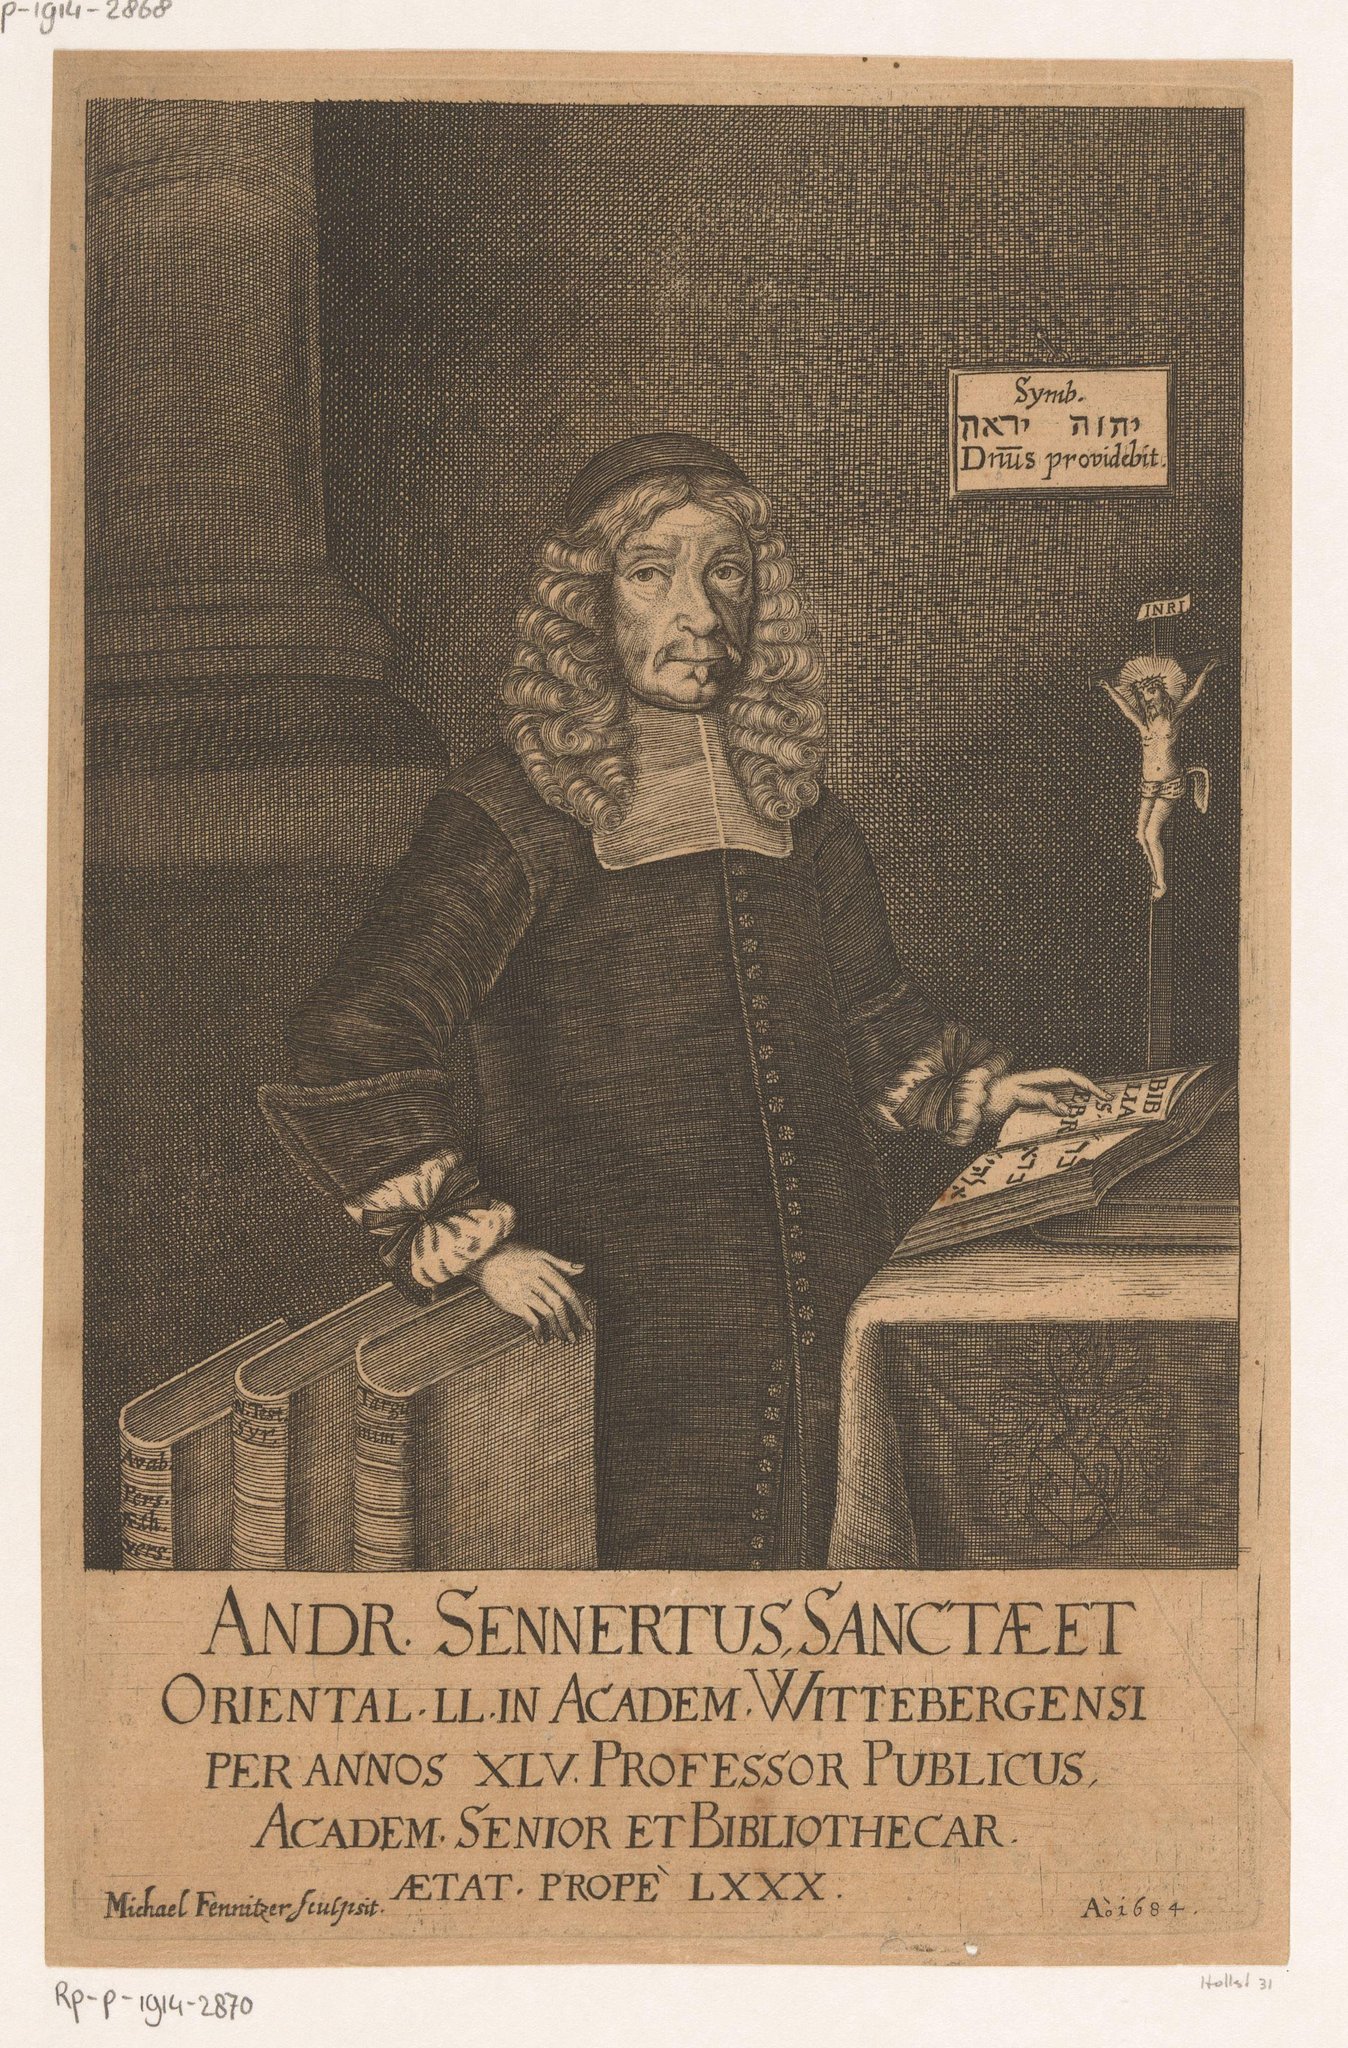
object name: print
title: Portret van Andreas Sennert op 80-jarige leeftijd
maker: michael fennitzer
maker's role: print maker, printer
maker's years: 1641-1702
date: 1684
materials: paper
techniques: engraving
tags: historical persons, book, crucifix ~ personal devotion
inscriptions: collector's mark: Lugt 2228